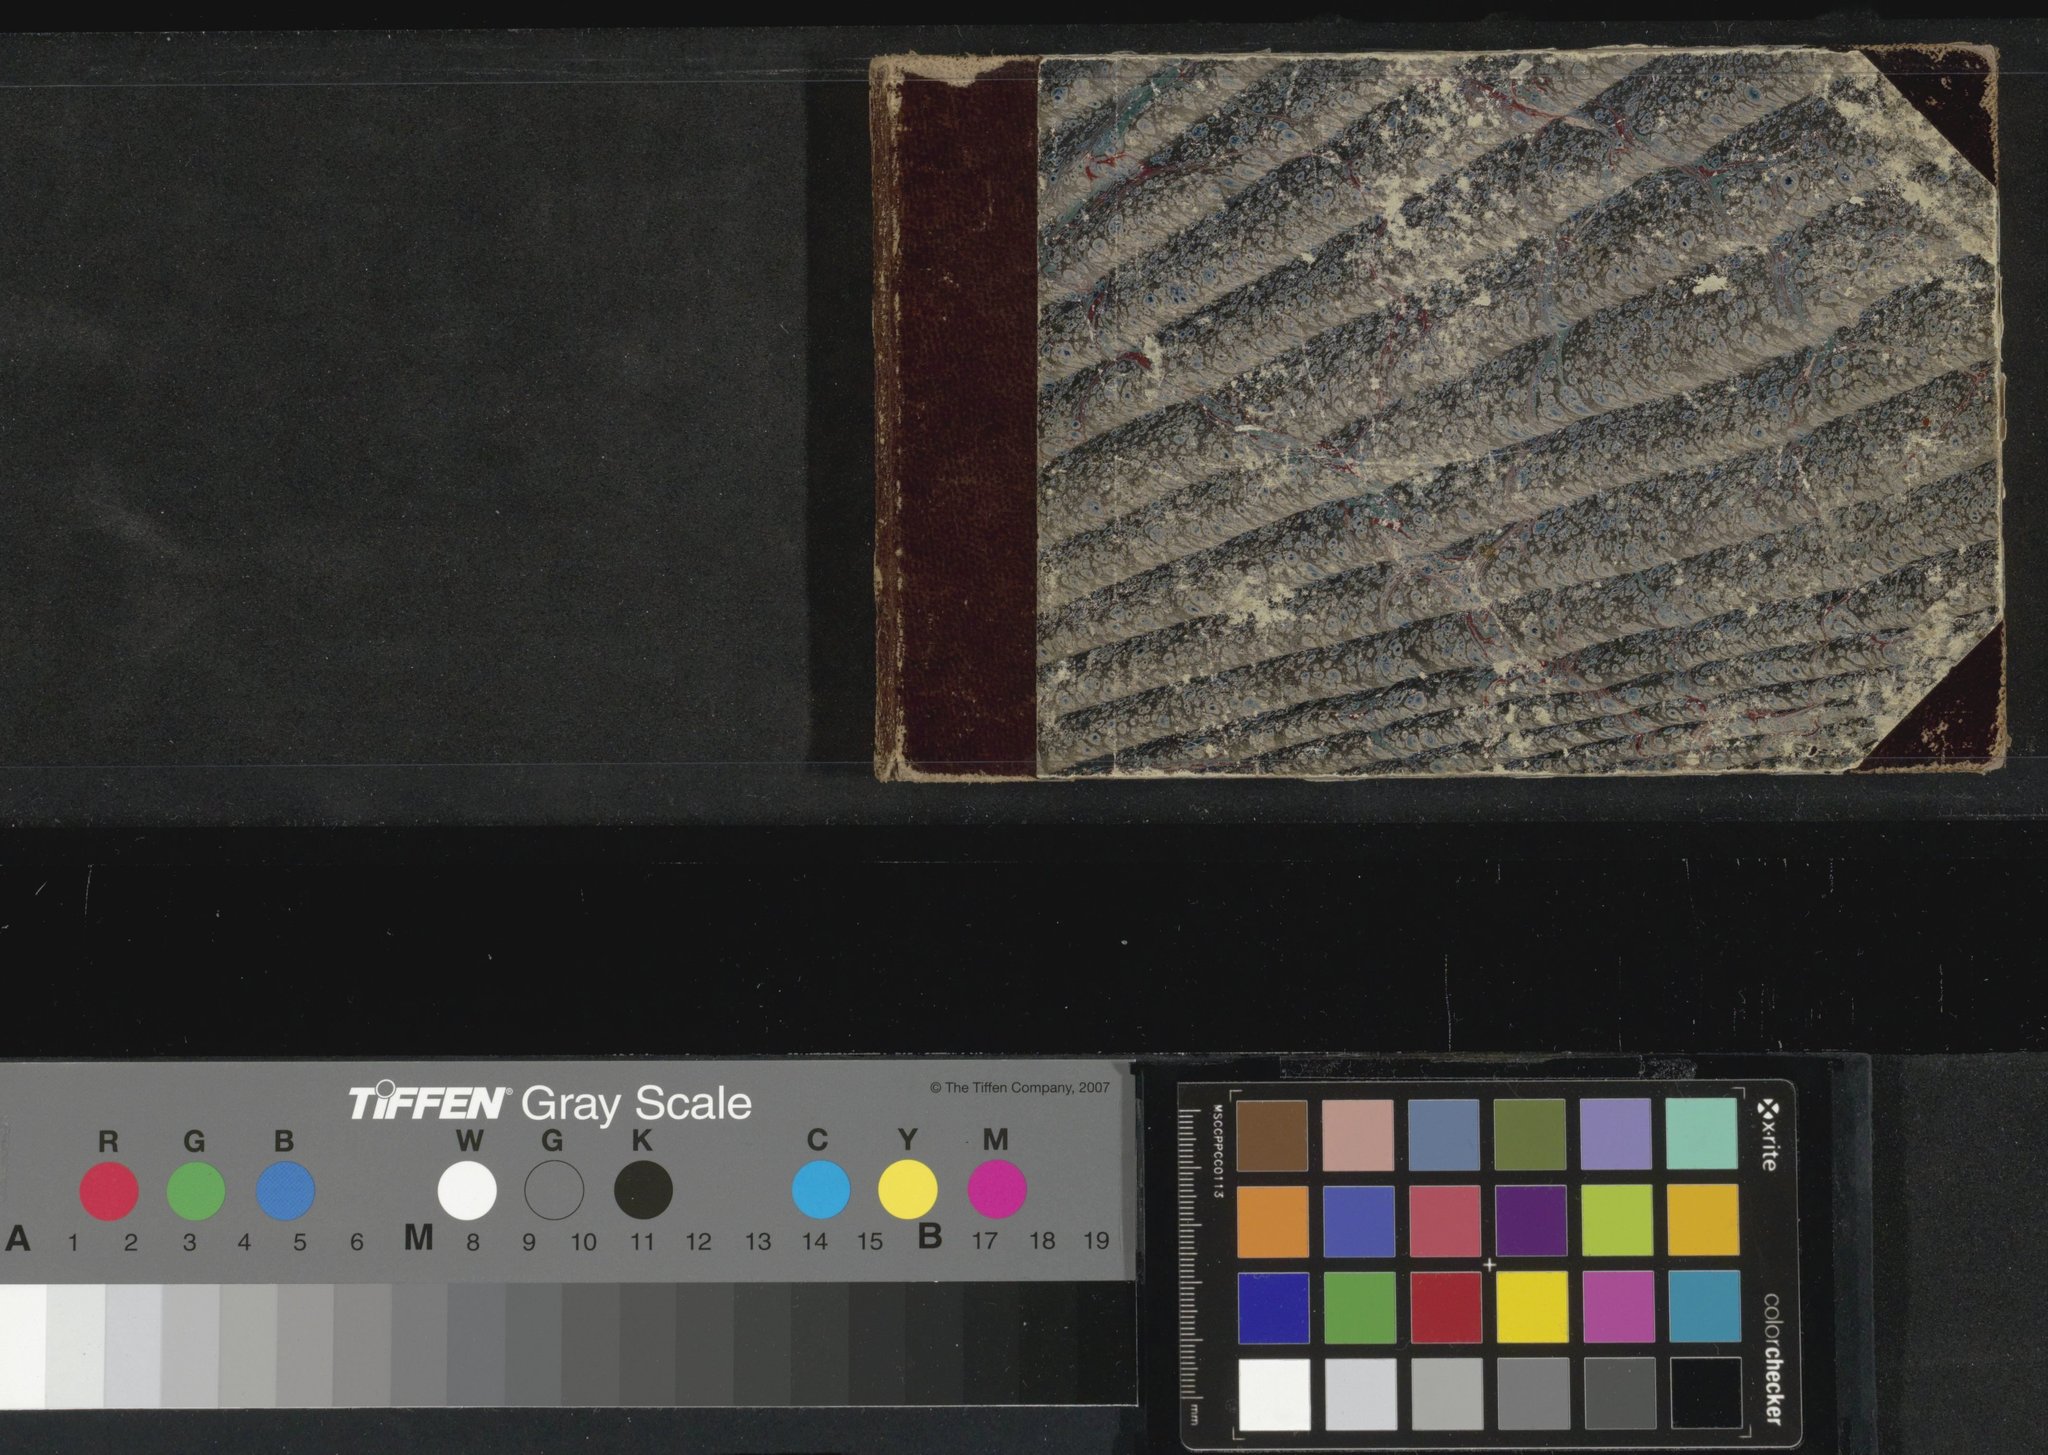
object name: sketchbook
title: Schetsboek met 61 bladen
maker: christian heinrich gottlieb steuerwald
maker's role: draughtsman, print maker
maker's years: 1802-1874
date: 1845-1848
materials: cardboard, ink, leather, paper, pencil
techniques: lithograph, pen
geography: baltic sea region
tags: animal traction, animal-drawn vehicle (carriage etc.), (military) uniforms, historical persons (portraits and scenes from the life)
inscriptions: collector's mark: Lugt 2228a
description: De volgende bladen uit het schetsboek zijn blanco: 1(R), 3(V), 4(R), 5(R), 6 t/m 8, 9(V), 10(R), 11(V), 12, 13(V), 15, 19(R), 20, 21(R), 22(R), 23(V), 24 t/m 31, 32(V), 33, 34, 35(R), 36, 37(R), 38 t/m 49, 50(R), 51 t/m 54, 55(R), 56 t/m 60 en 61(R).